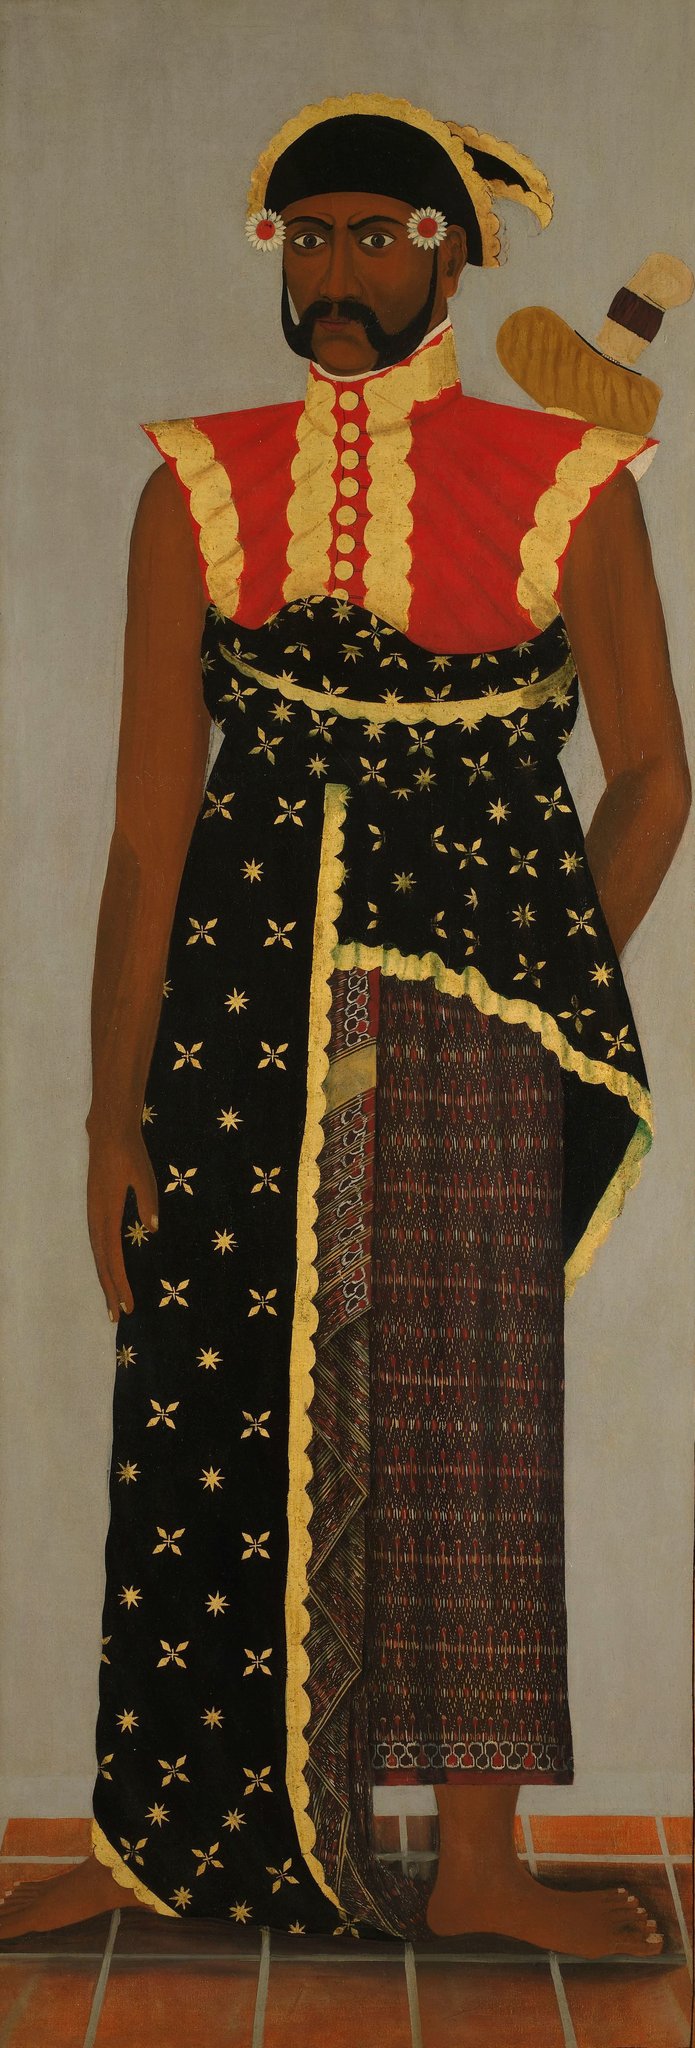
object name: painting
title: Javanese Court Officials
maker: Anonymous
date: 1820-1870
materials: cotton, oil, paint, paper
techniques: gilding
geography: java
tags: hacking and thrusting weapons, anonymous historical person portrayed alone, royal household; courtiers, retinue, train, regent, substitute ruler; viceroy, java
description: These five figures are representatives of the Javanese elite. The accurately depicted clothing and batik motifs signal where they come from and what their rank and status are. Knowledge of their etiquette and appearance was of great political importance to the colonial administration. The Javanese elite was increasingly deployed to control and exploit the colony in the first half of the 19th century.